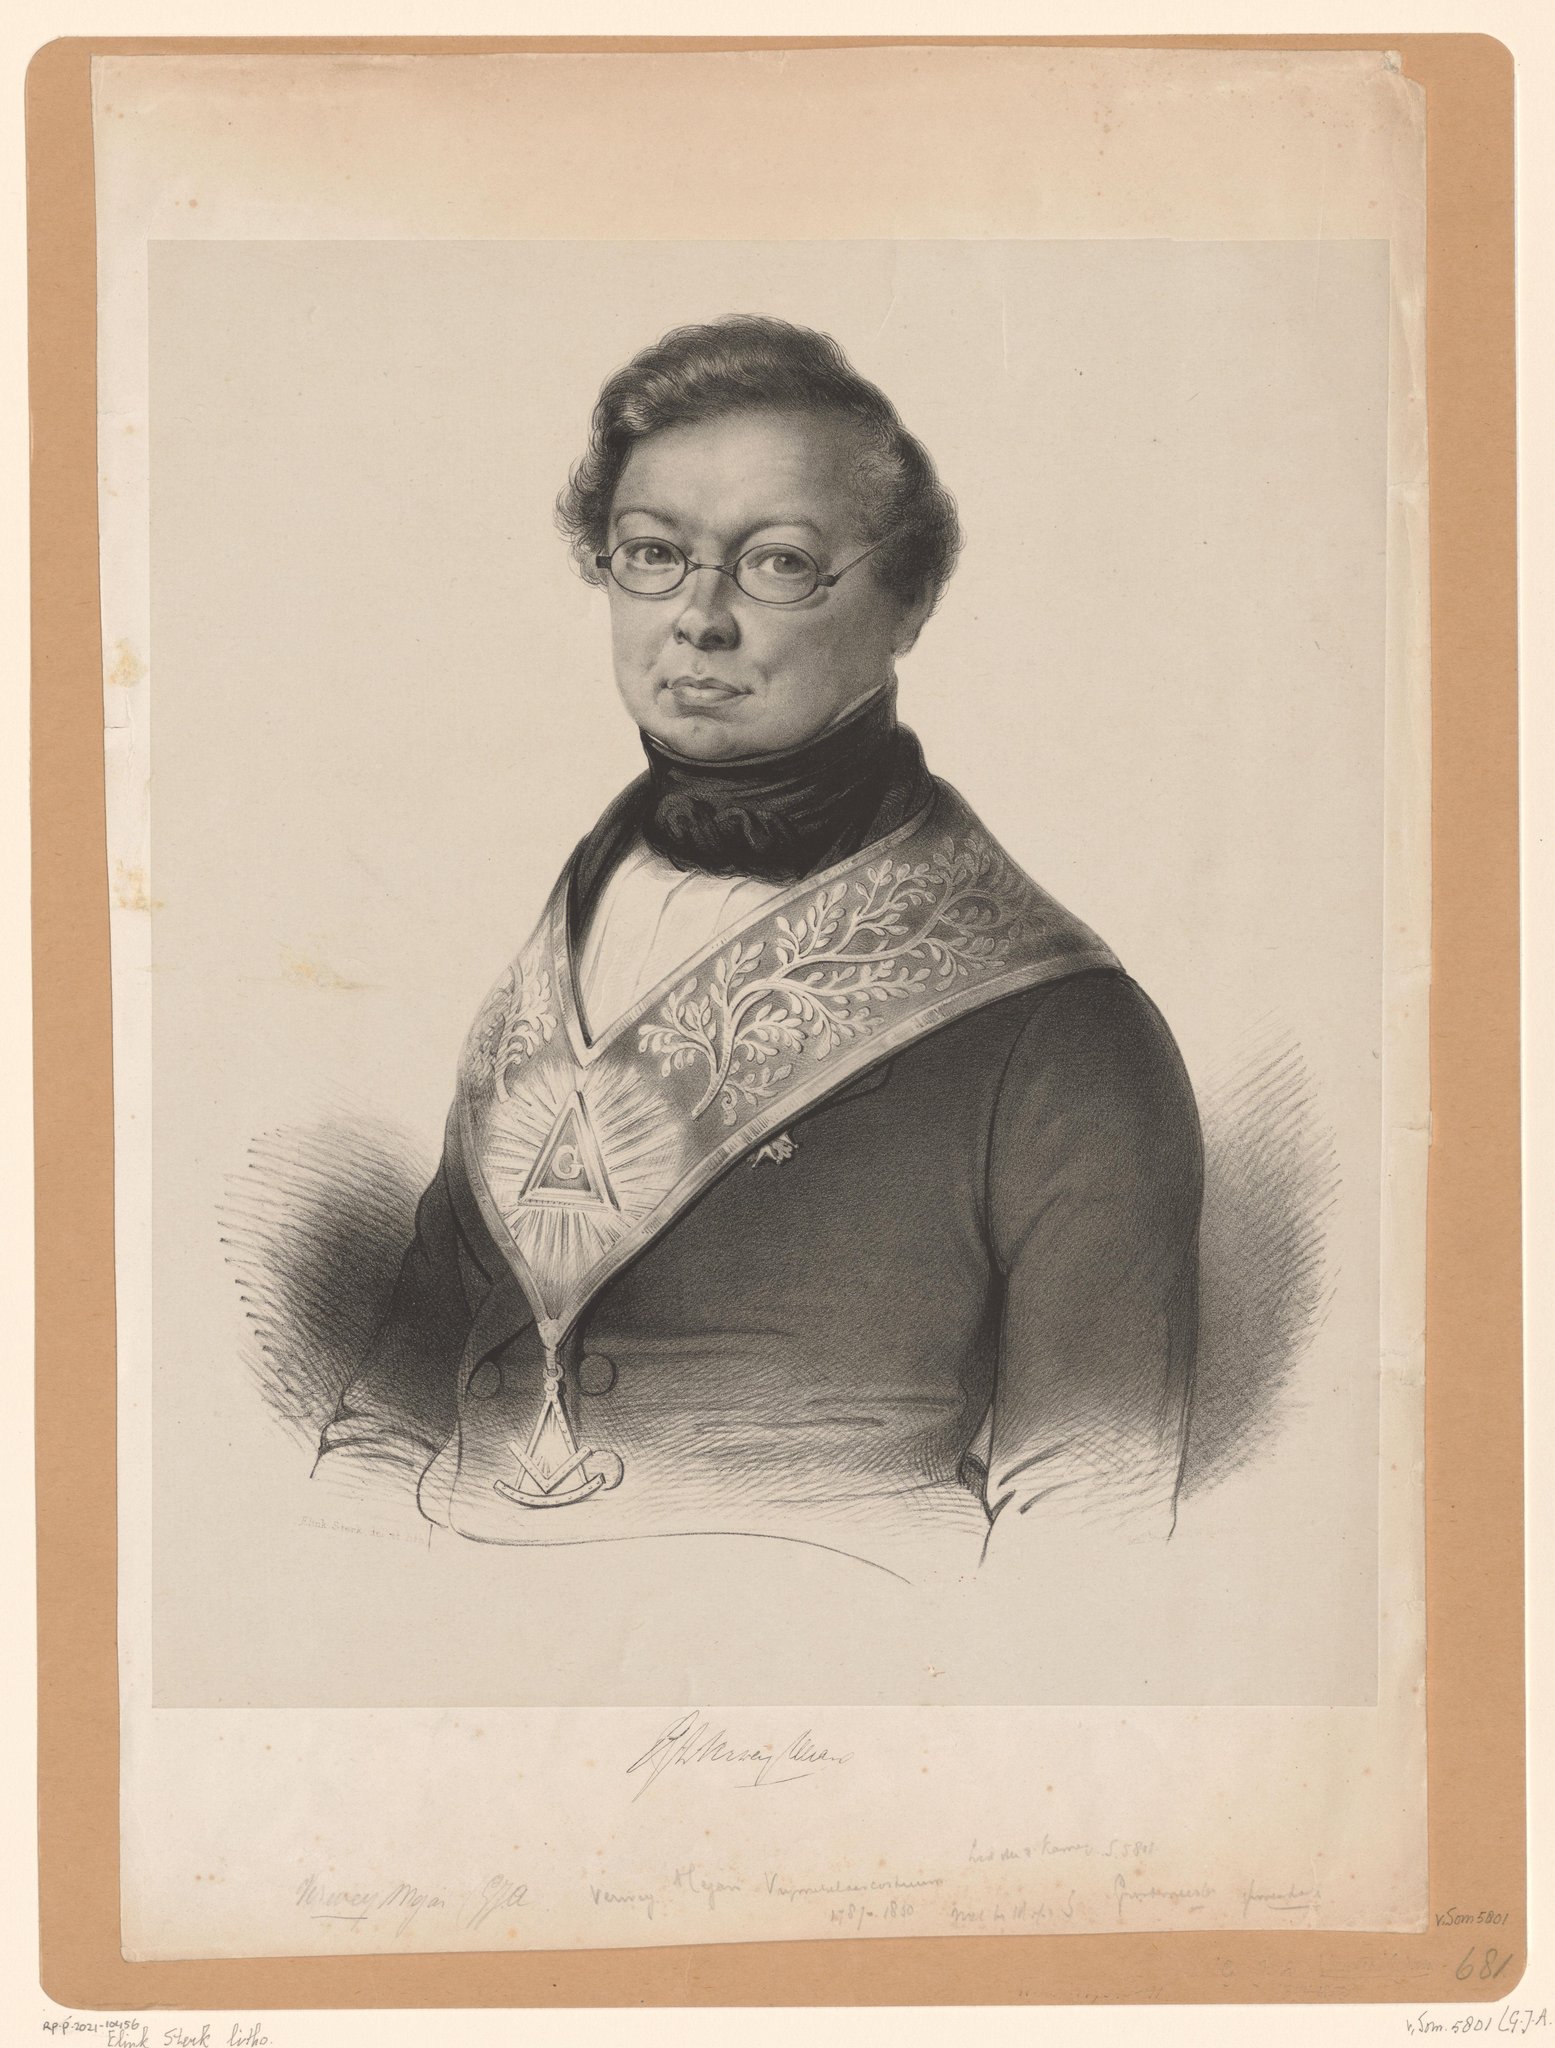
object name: print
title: Portret van Gerardus Wouter Verweij Mejan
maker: isaac cornelis elink sterk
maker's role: print maker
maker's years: 1808-1871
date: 1830-1850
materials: paper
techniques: lithograph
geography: the hague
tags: the hague, eyeglasses, spectacles, historical persons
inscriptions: mark: ‘M./ vS.’, collector's mark: ‘I.B.’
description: De geportretteerde draagt een vrijmetselaarskostuum met een hanger met de passer en winkelhaak. Hij draagt ook een bril en een ridderorde op zijn borst. Onder het portret zijn signatuur.